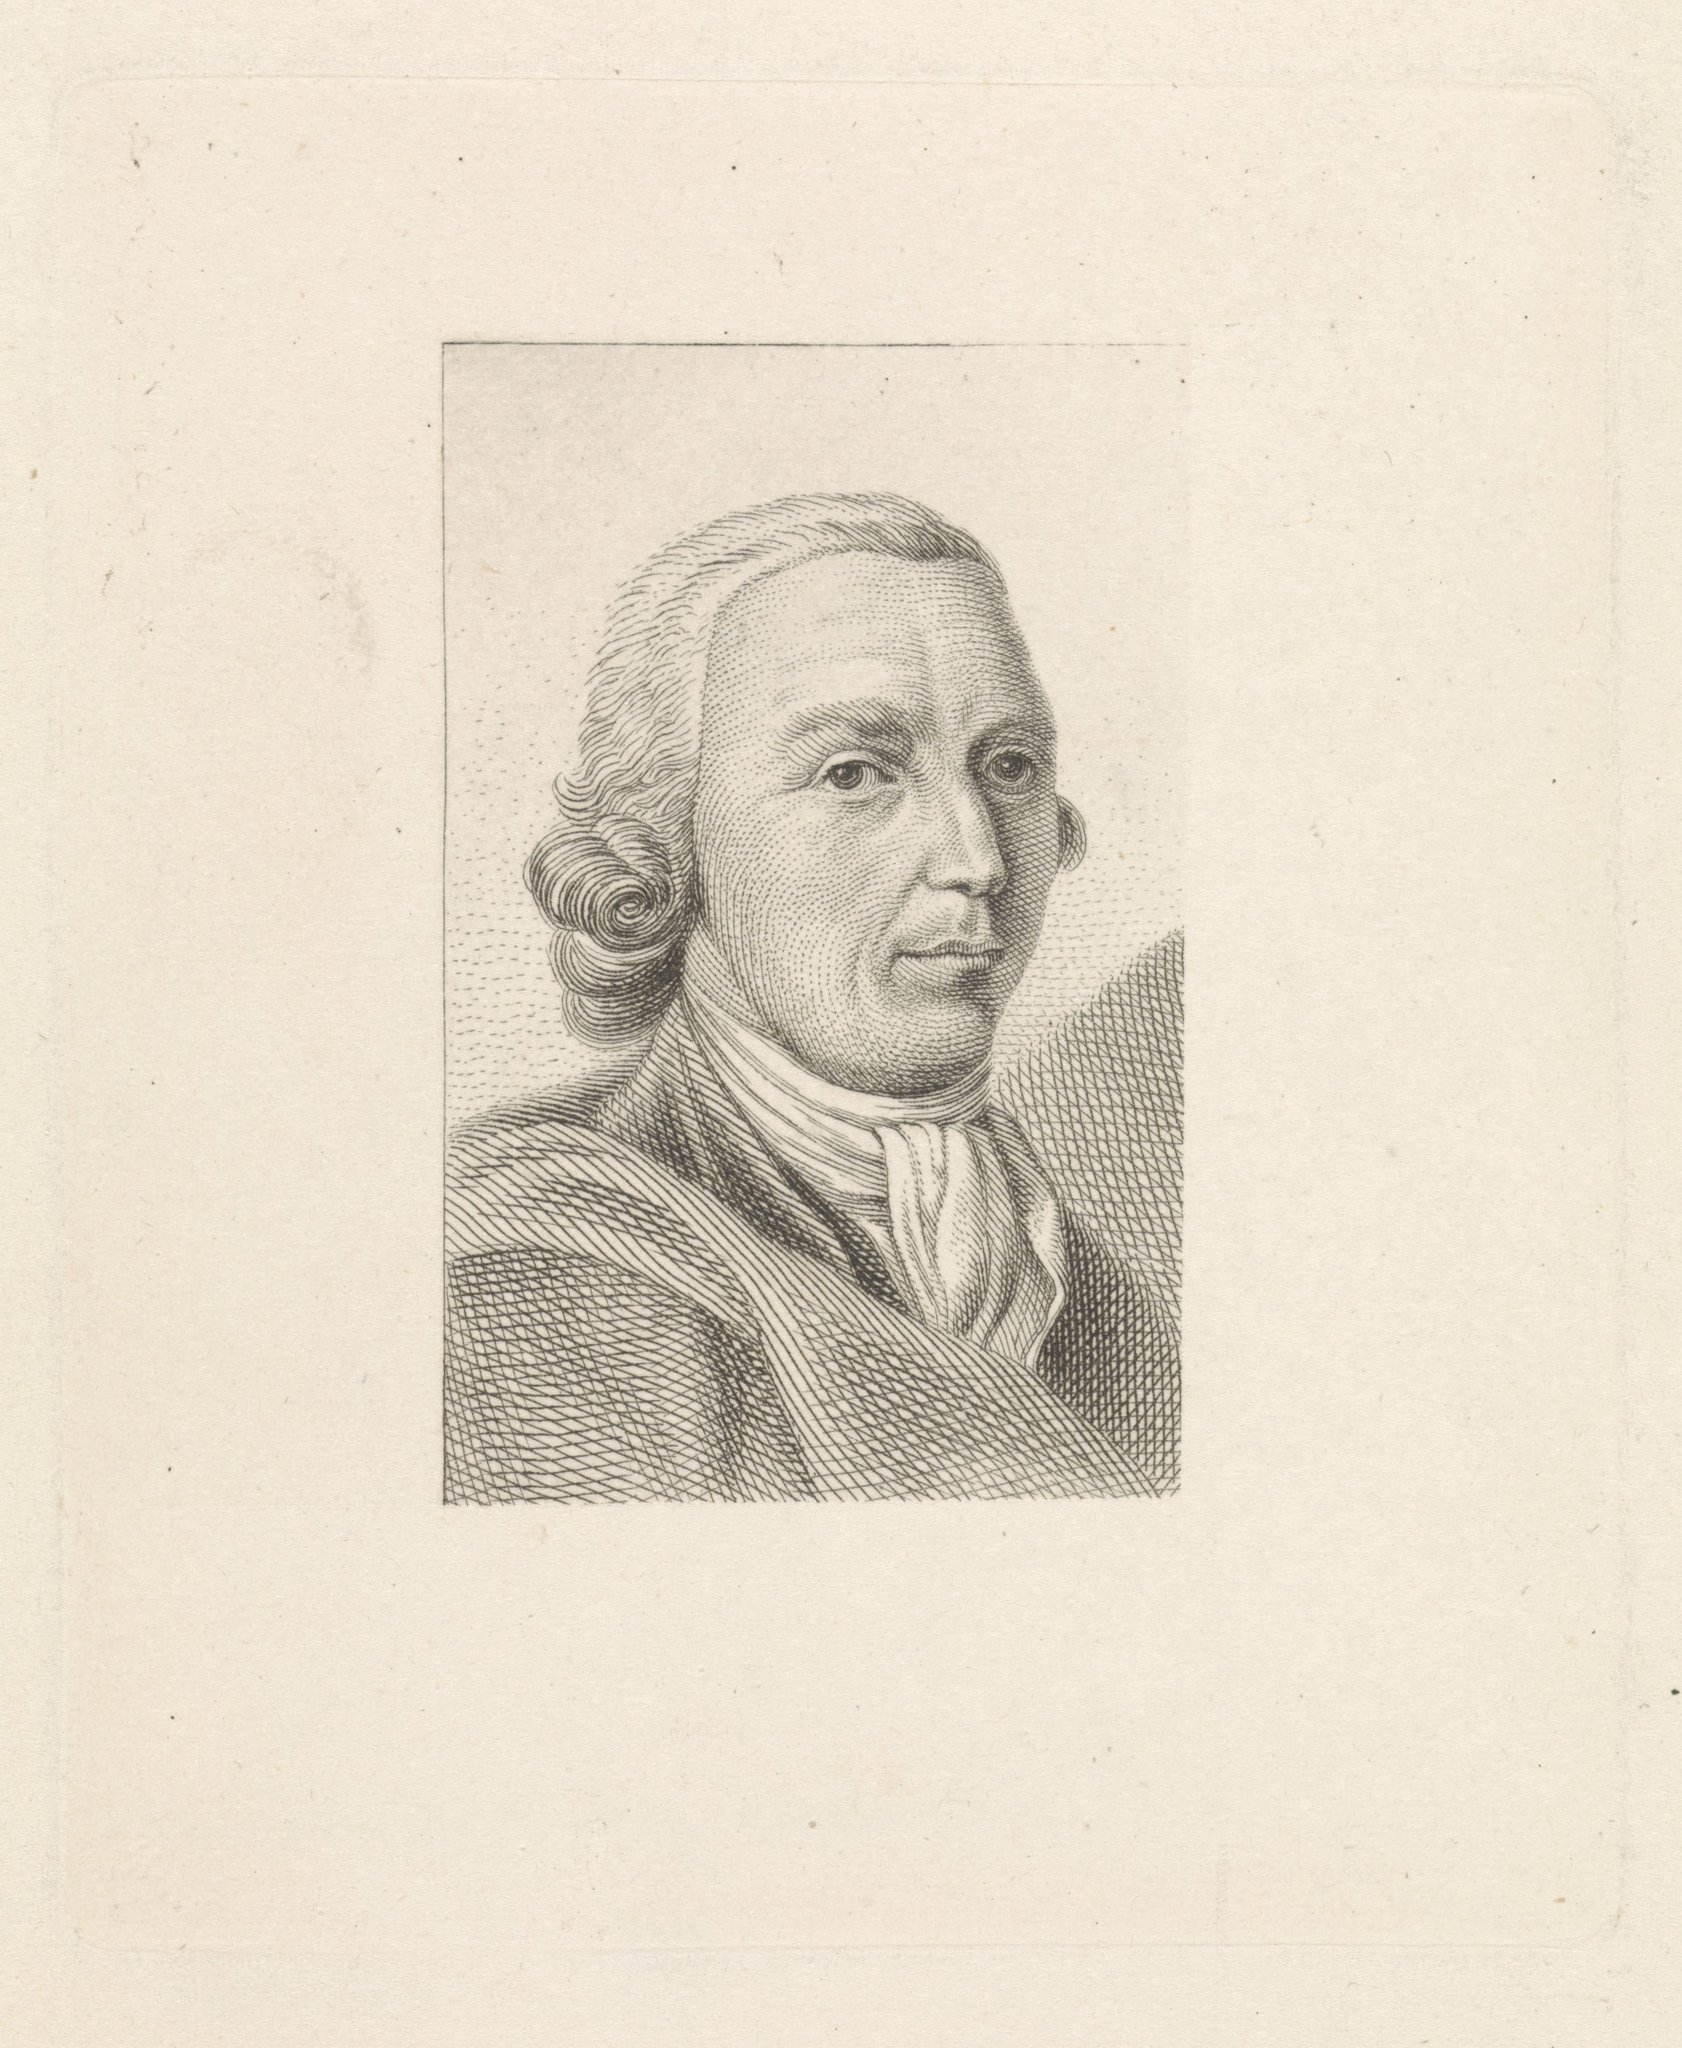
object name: print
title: Portret van Pieter Barbiers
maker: jacob ernst marcus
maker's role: draughtsman, print maker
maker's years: 1774-1826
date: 1817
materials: paper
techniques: engraving, etching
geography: amsterdam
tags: amsterdam, print maker, pieter barbiers (i)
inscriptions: collector's mark: Lugt 2760, collector's mark: Lugt 2228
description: Latere staat van de gehele prent gebruikt in: Roeland van Eynden, Adriaan van der Willigen, Geschiedenis der vaderlansche schilderkunst, sedert de helft der XVIII eeuw. Haarlem, A. Loosjes, Pz [vanaf dl 3: Wed. A. Loosjes], 4 dln., 1816-40.